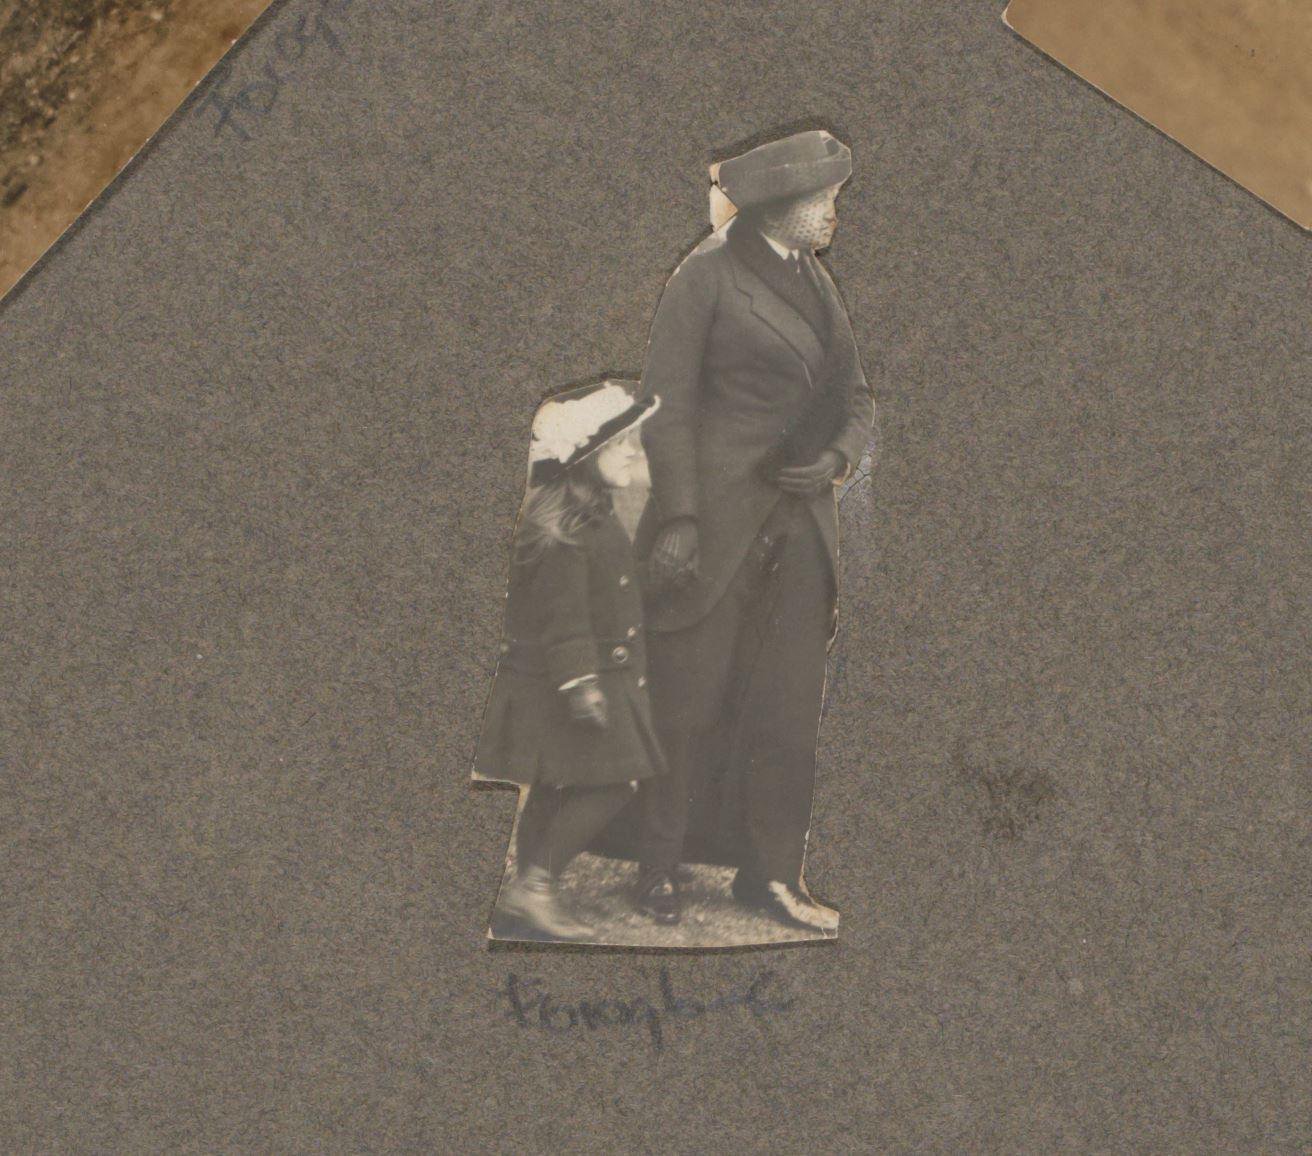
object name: album leaf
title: Vrouw met kind, vermoedelijk op Koninklijke Houtvesterij Het Loo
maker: Anonymous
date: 1900-1920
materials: photographic support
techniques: gelatin silver print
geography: het loo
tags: mother and baby or young child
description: Onderdeel van Fotoalbum van de heer Brams, opperhoutvester van koningin Wilhelmina op Koninklijke Houtvesterij Het Loo.